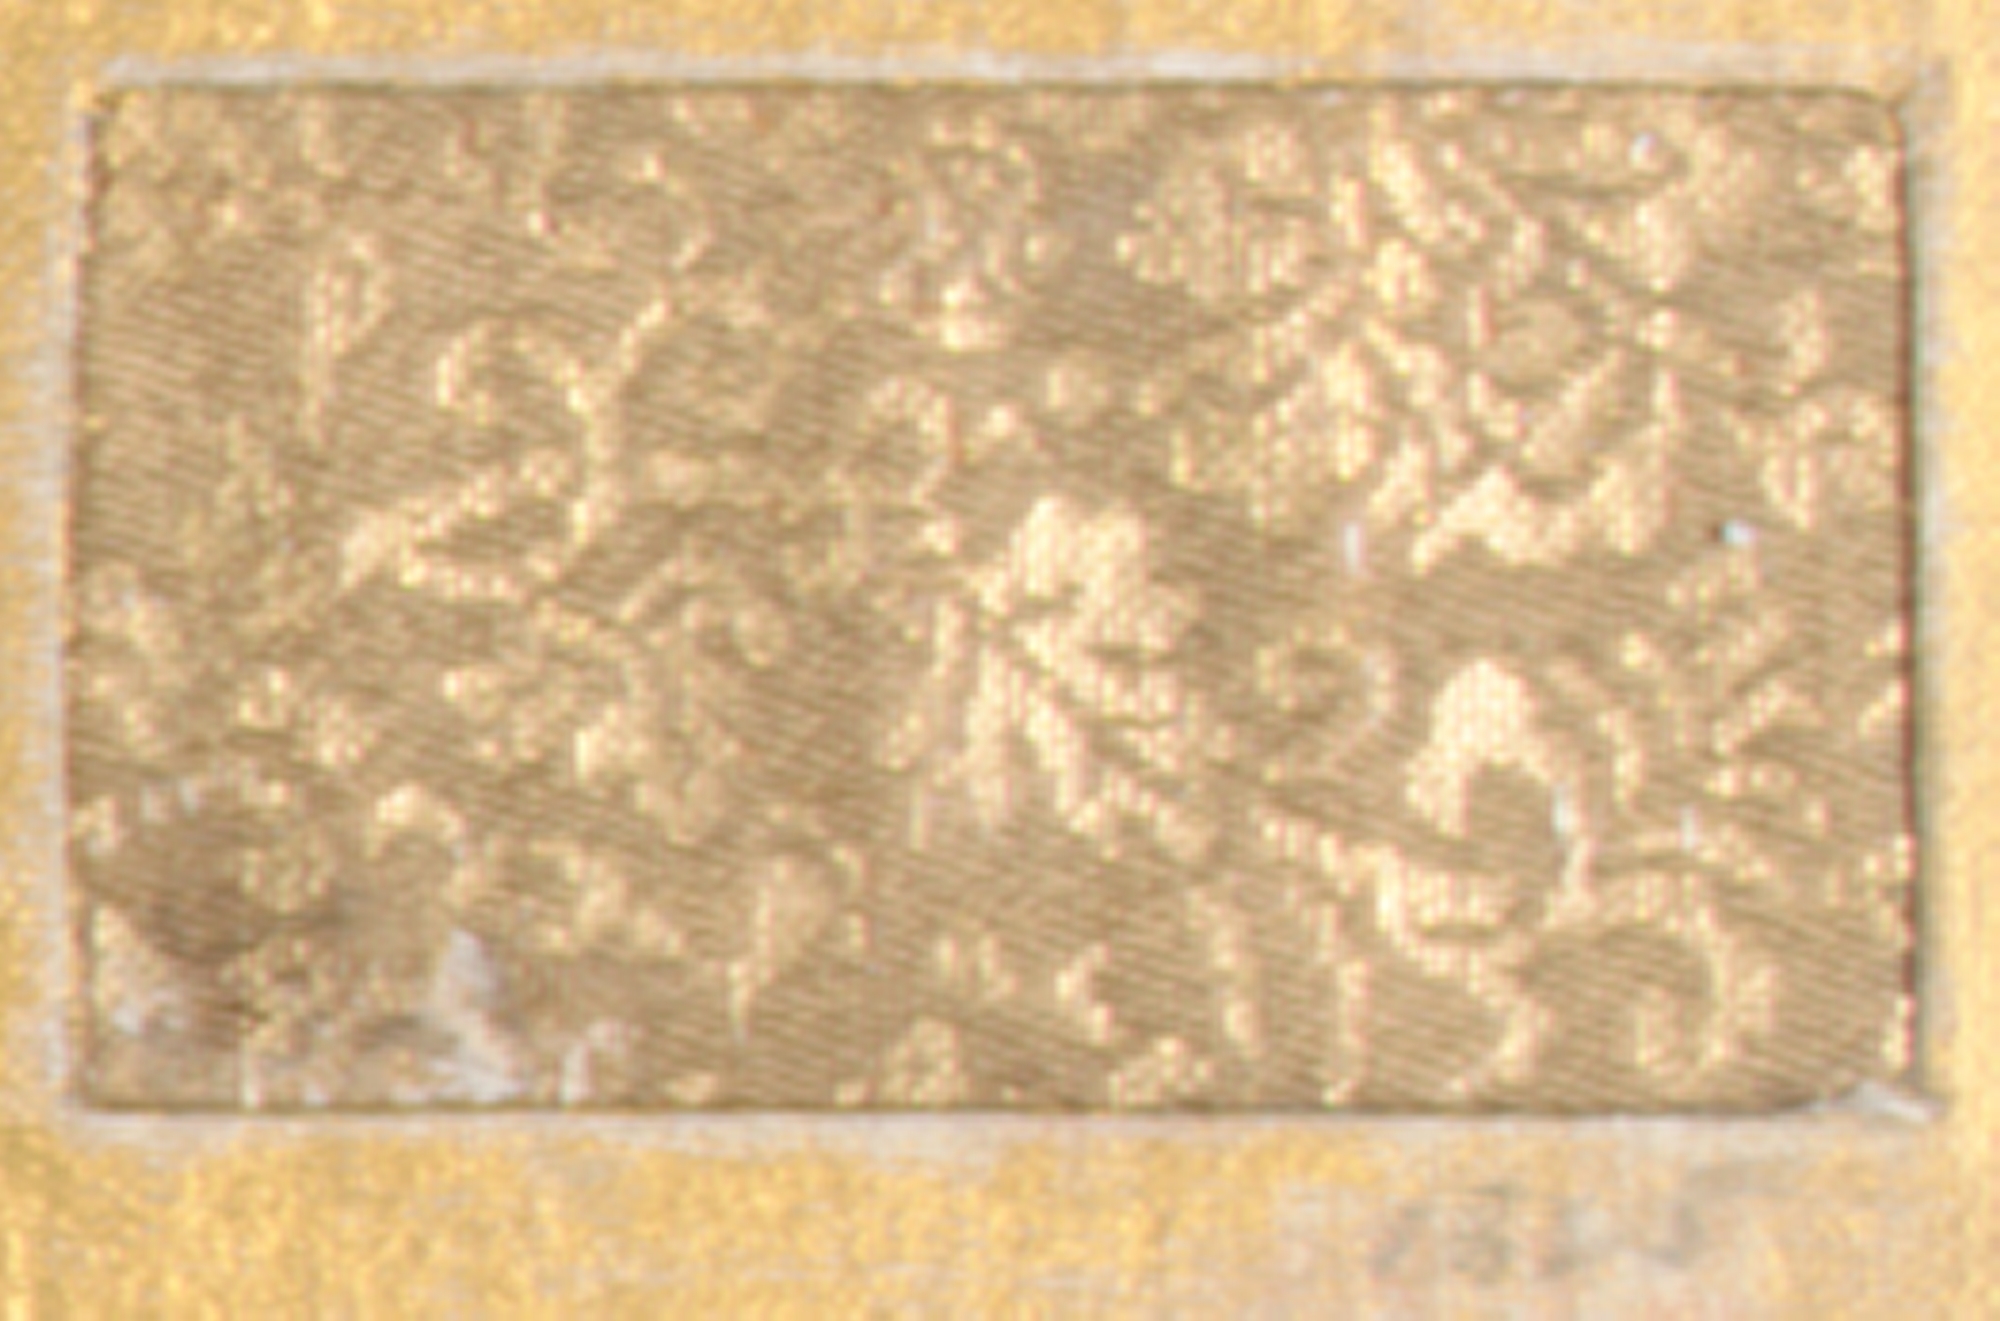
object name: piece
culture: japanese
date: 1701-1900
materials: silk